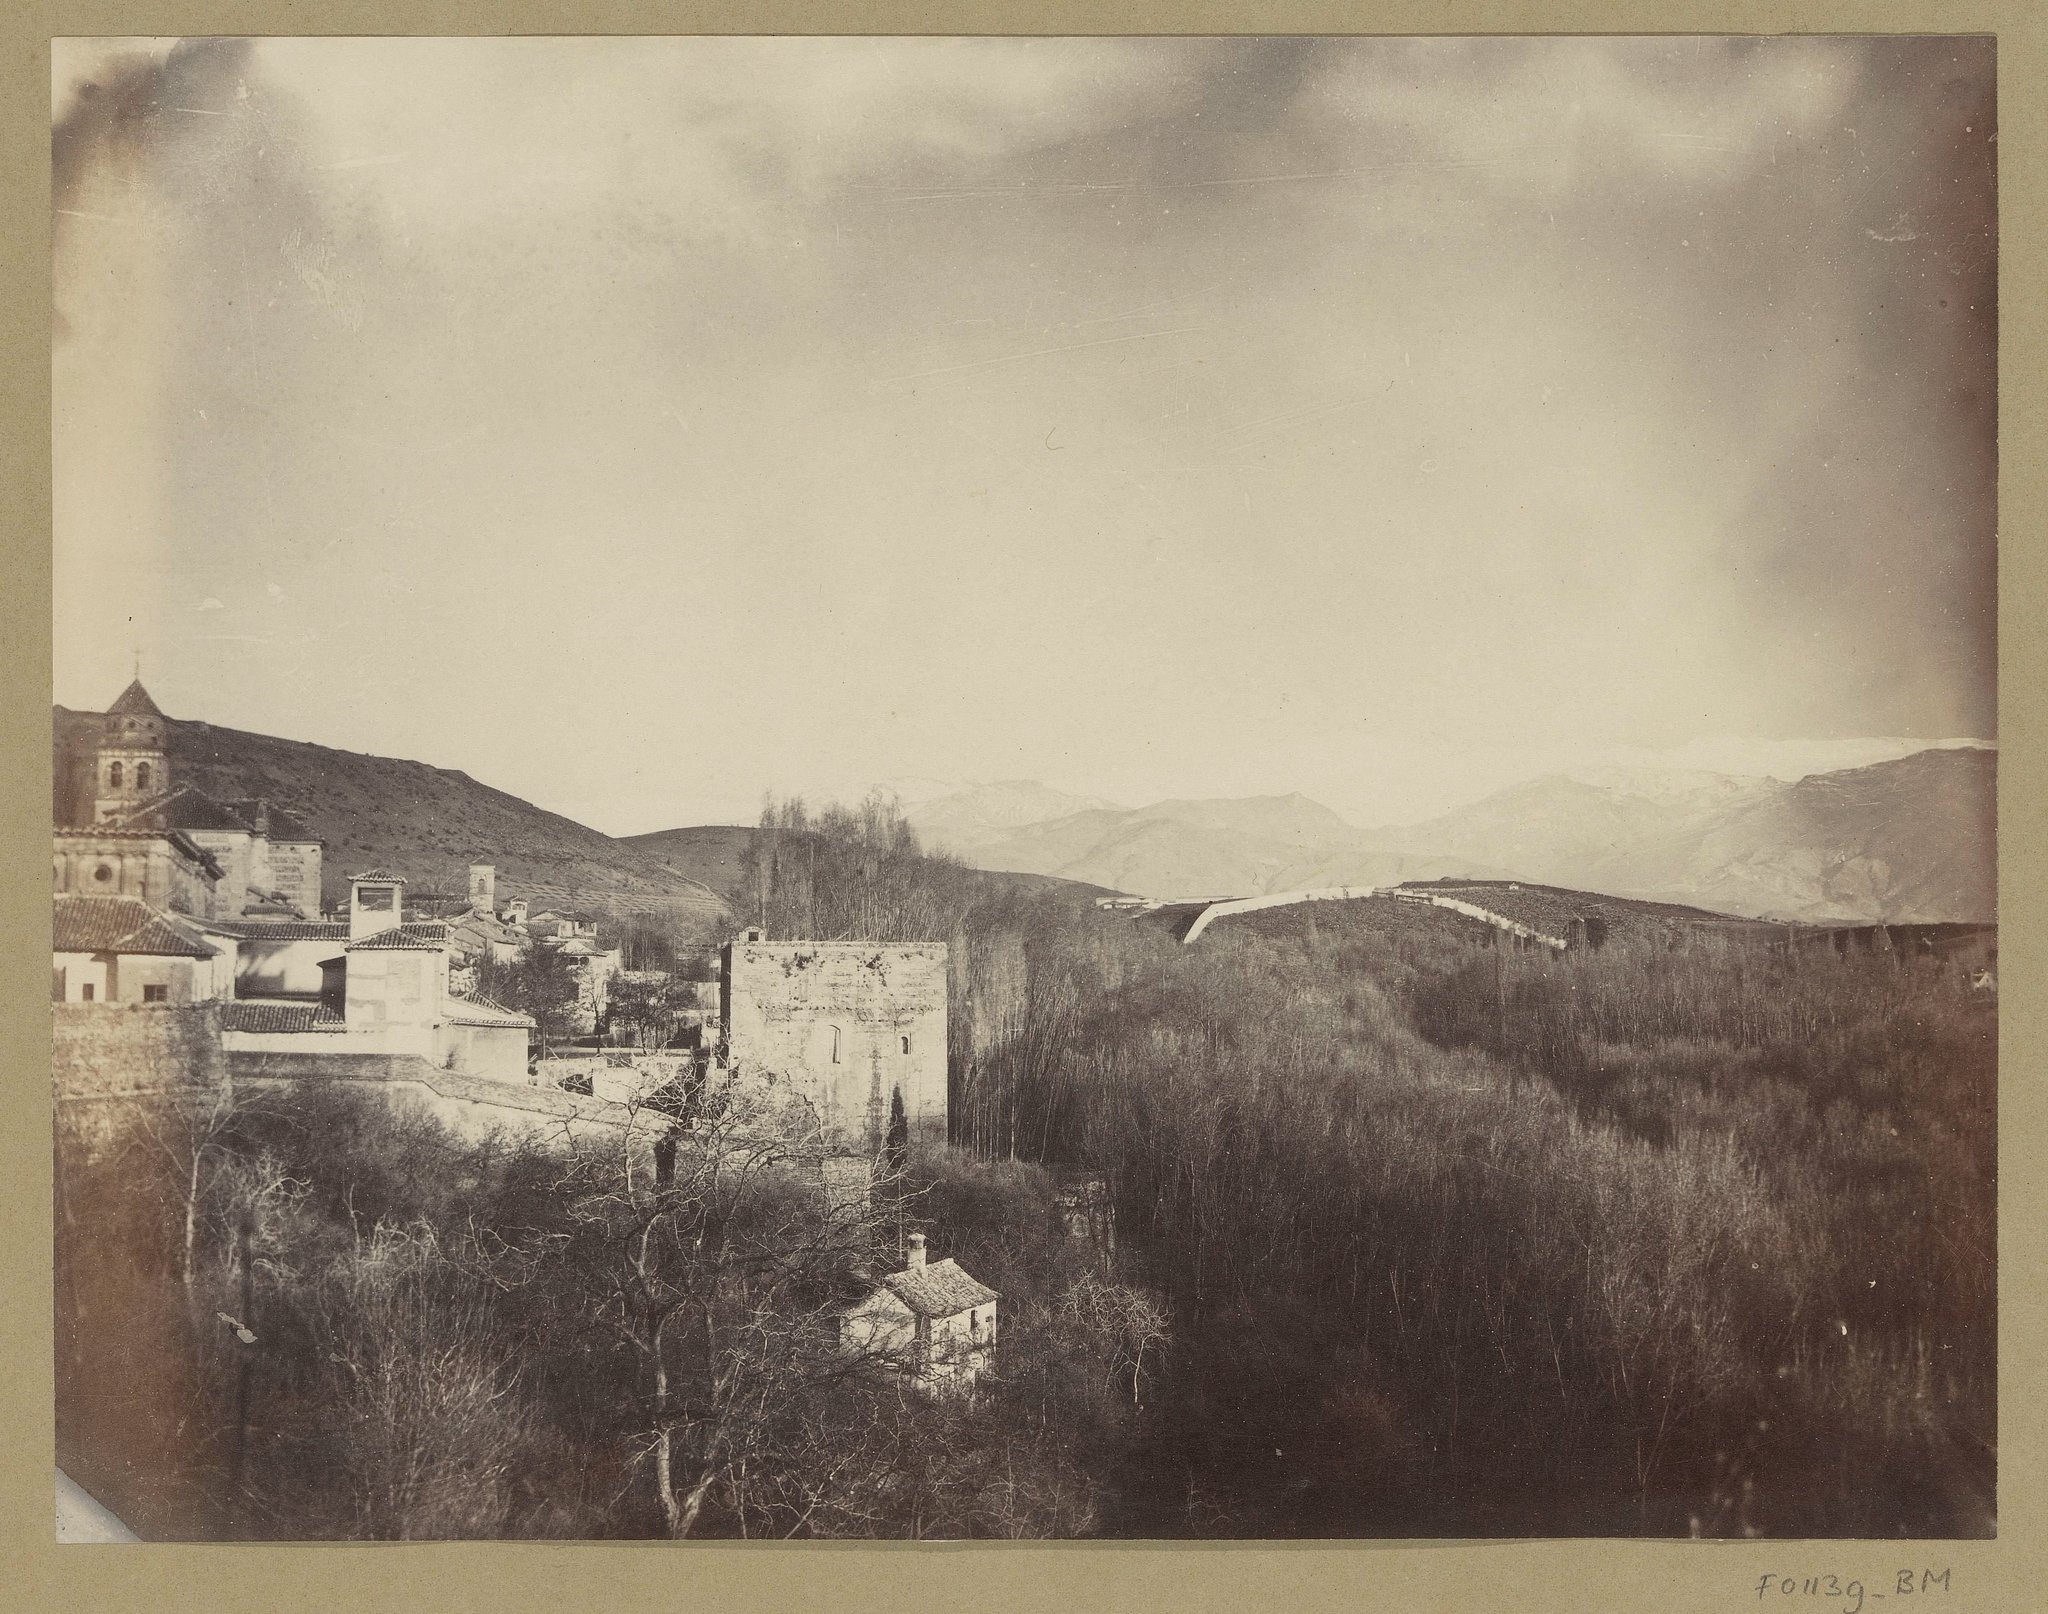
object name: album leaf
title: Gezicht op Granada en de Sierra Nevada, links het Alhambra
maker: Anonymous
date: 1851-1890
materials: paper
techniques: albumen print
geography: granada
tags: city-view in general; 'veduta', mountains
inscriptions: inscription: ‘Granada’